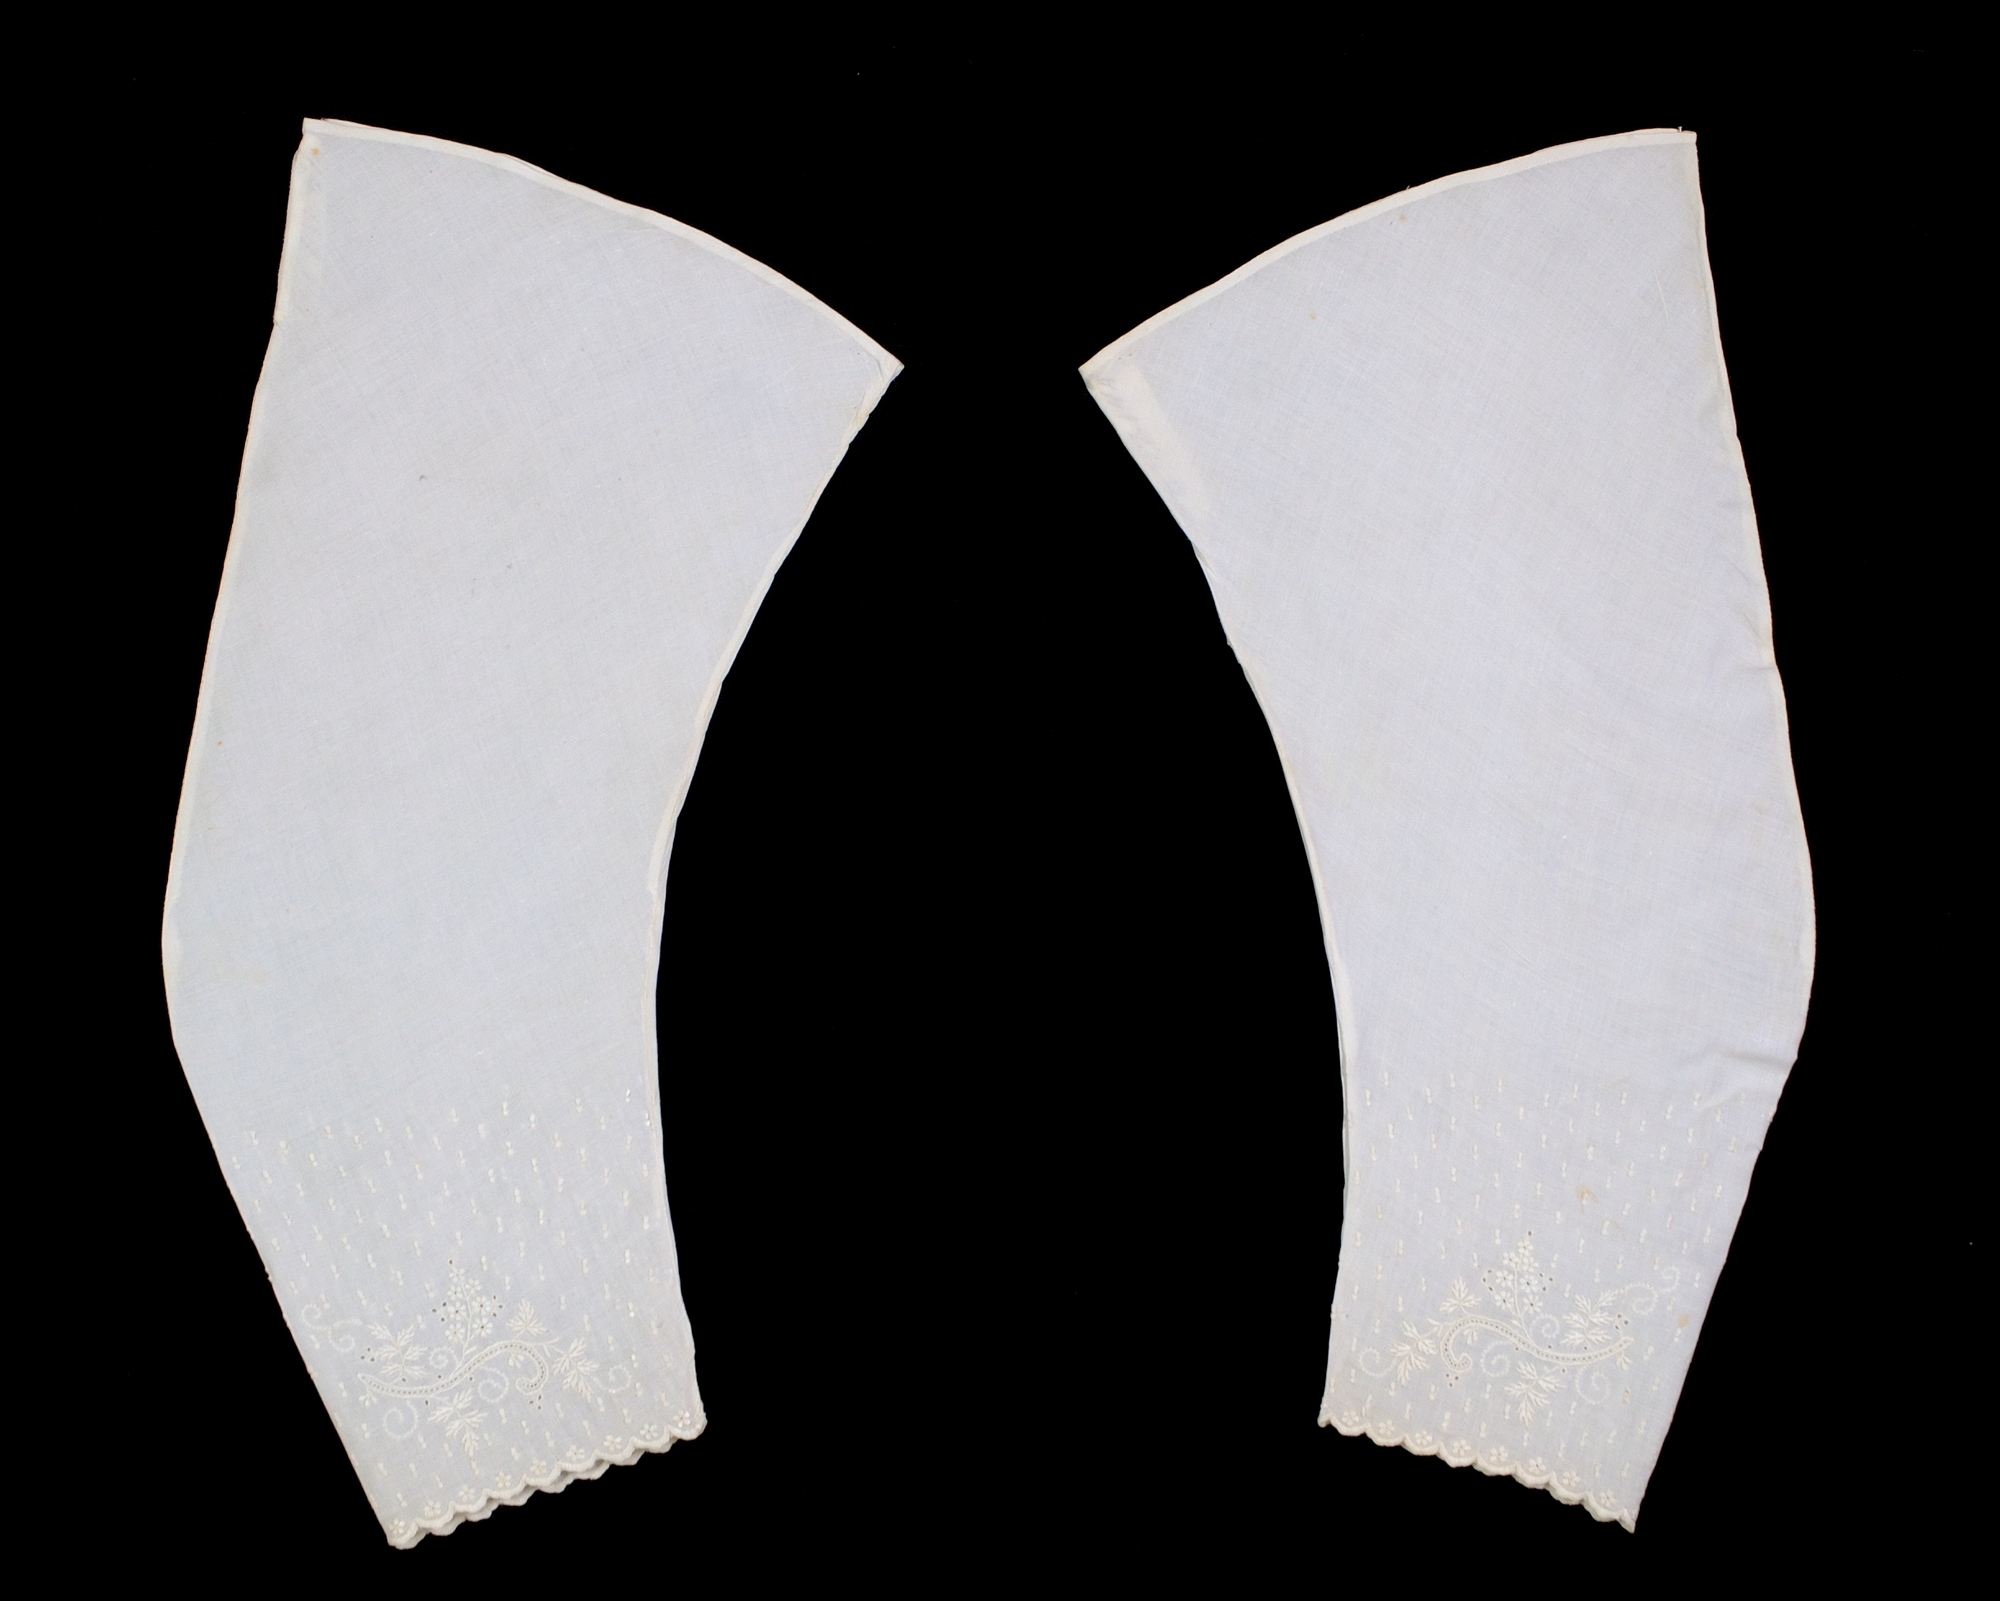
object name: undersleeves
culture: american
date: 1826-1850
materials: linen